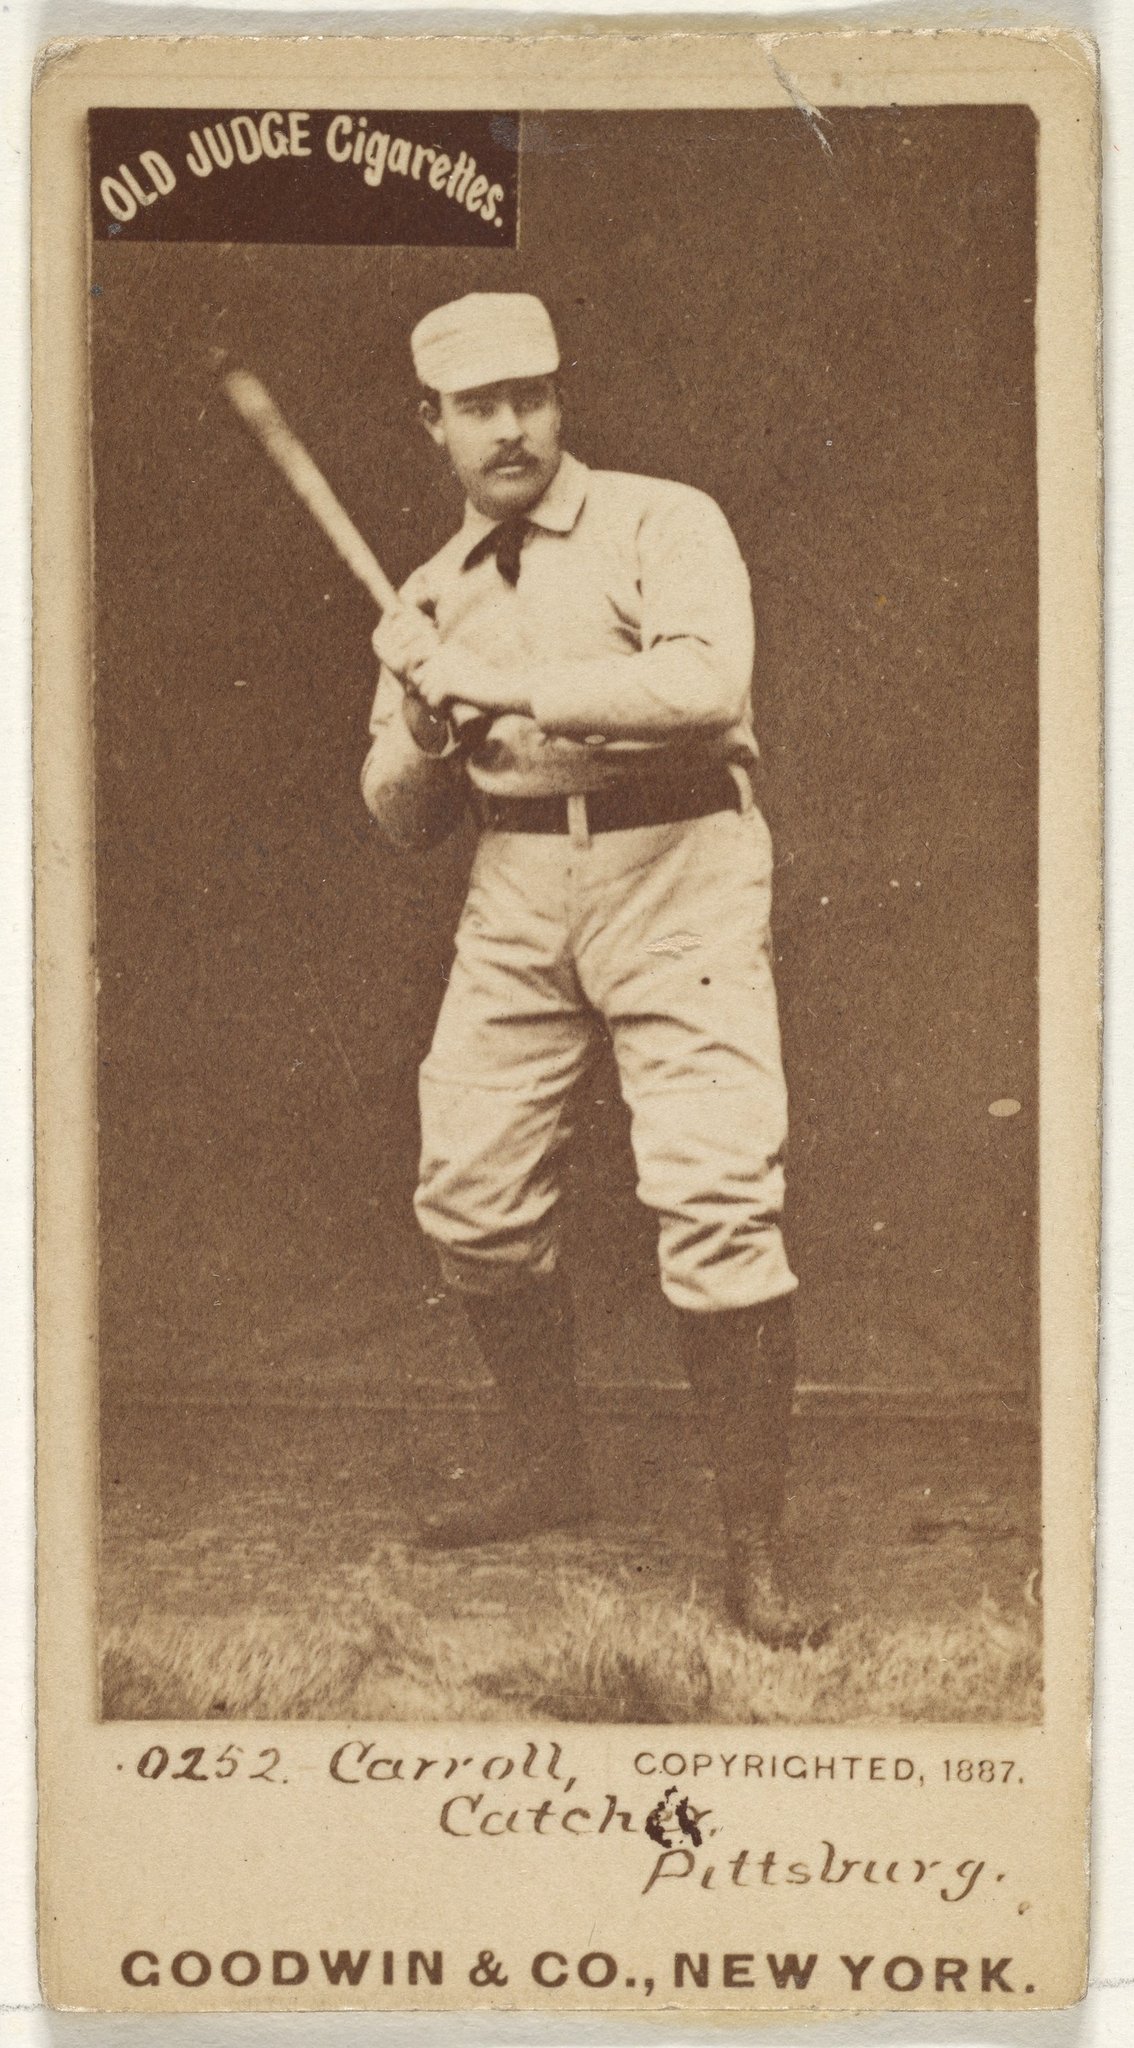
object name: baseball card, photograph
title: Frederick " Fred" Herbert Carroll, Catcher, Pittsburgh, from the Old Judge series (N172) for Old Judge Cigarettes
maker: goodwin & company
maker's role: publisher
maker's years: 1850-1950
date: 1887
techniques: albumen silver print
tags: men,portraits,baseball,athletes